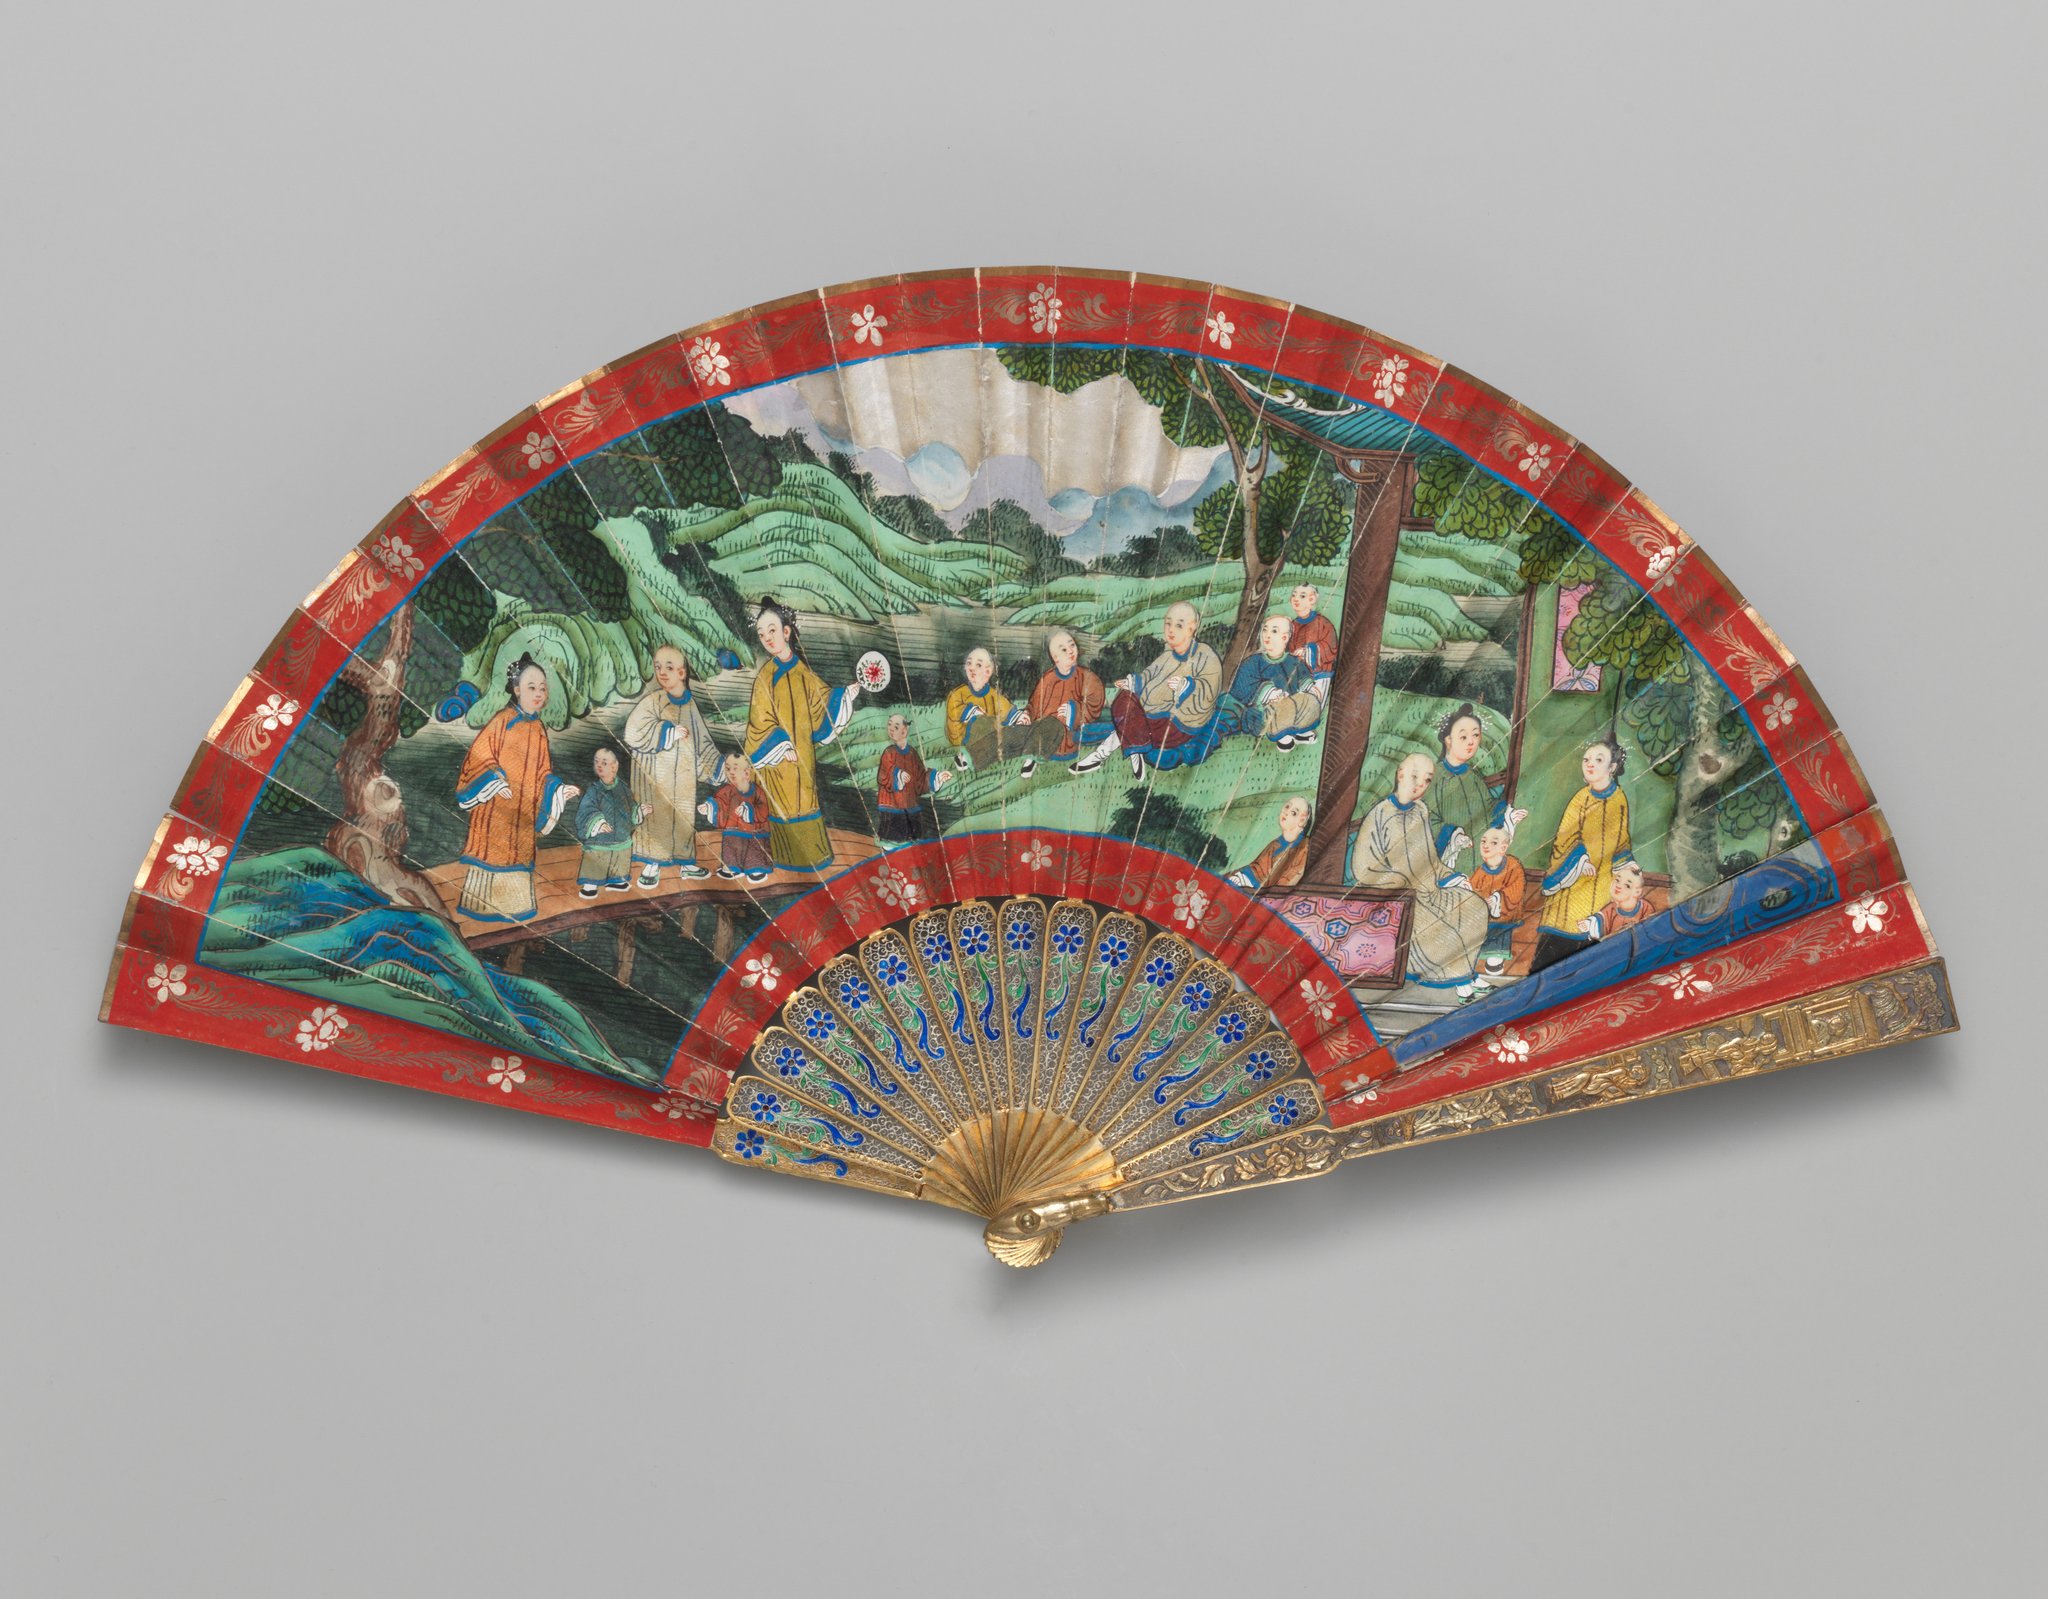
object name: fan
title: Folding Fan with Scene of Figures in a Landscape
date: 1801-1900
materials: brass, paper, silk, silver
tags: children,men,women,landscapes